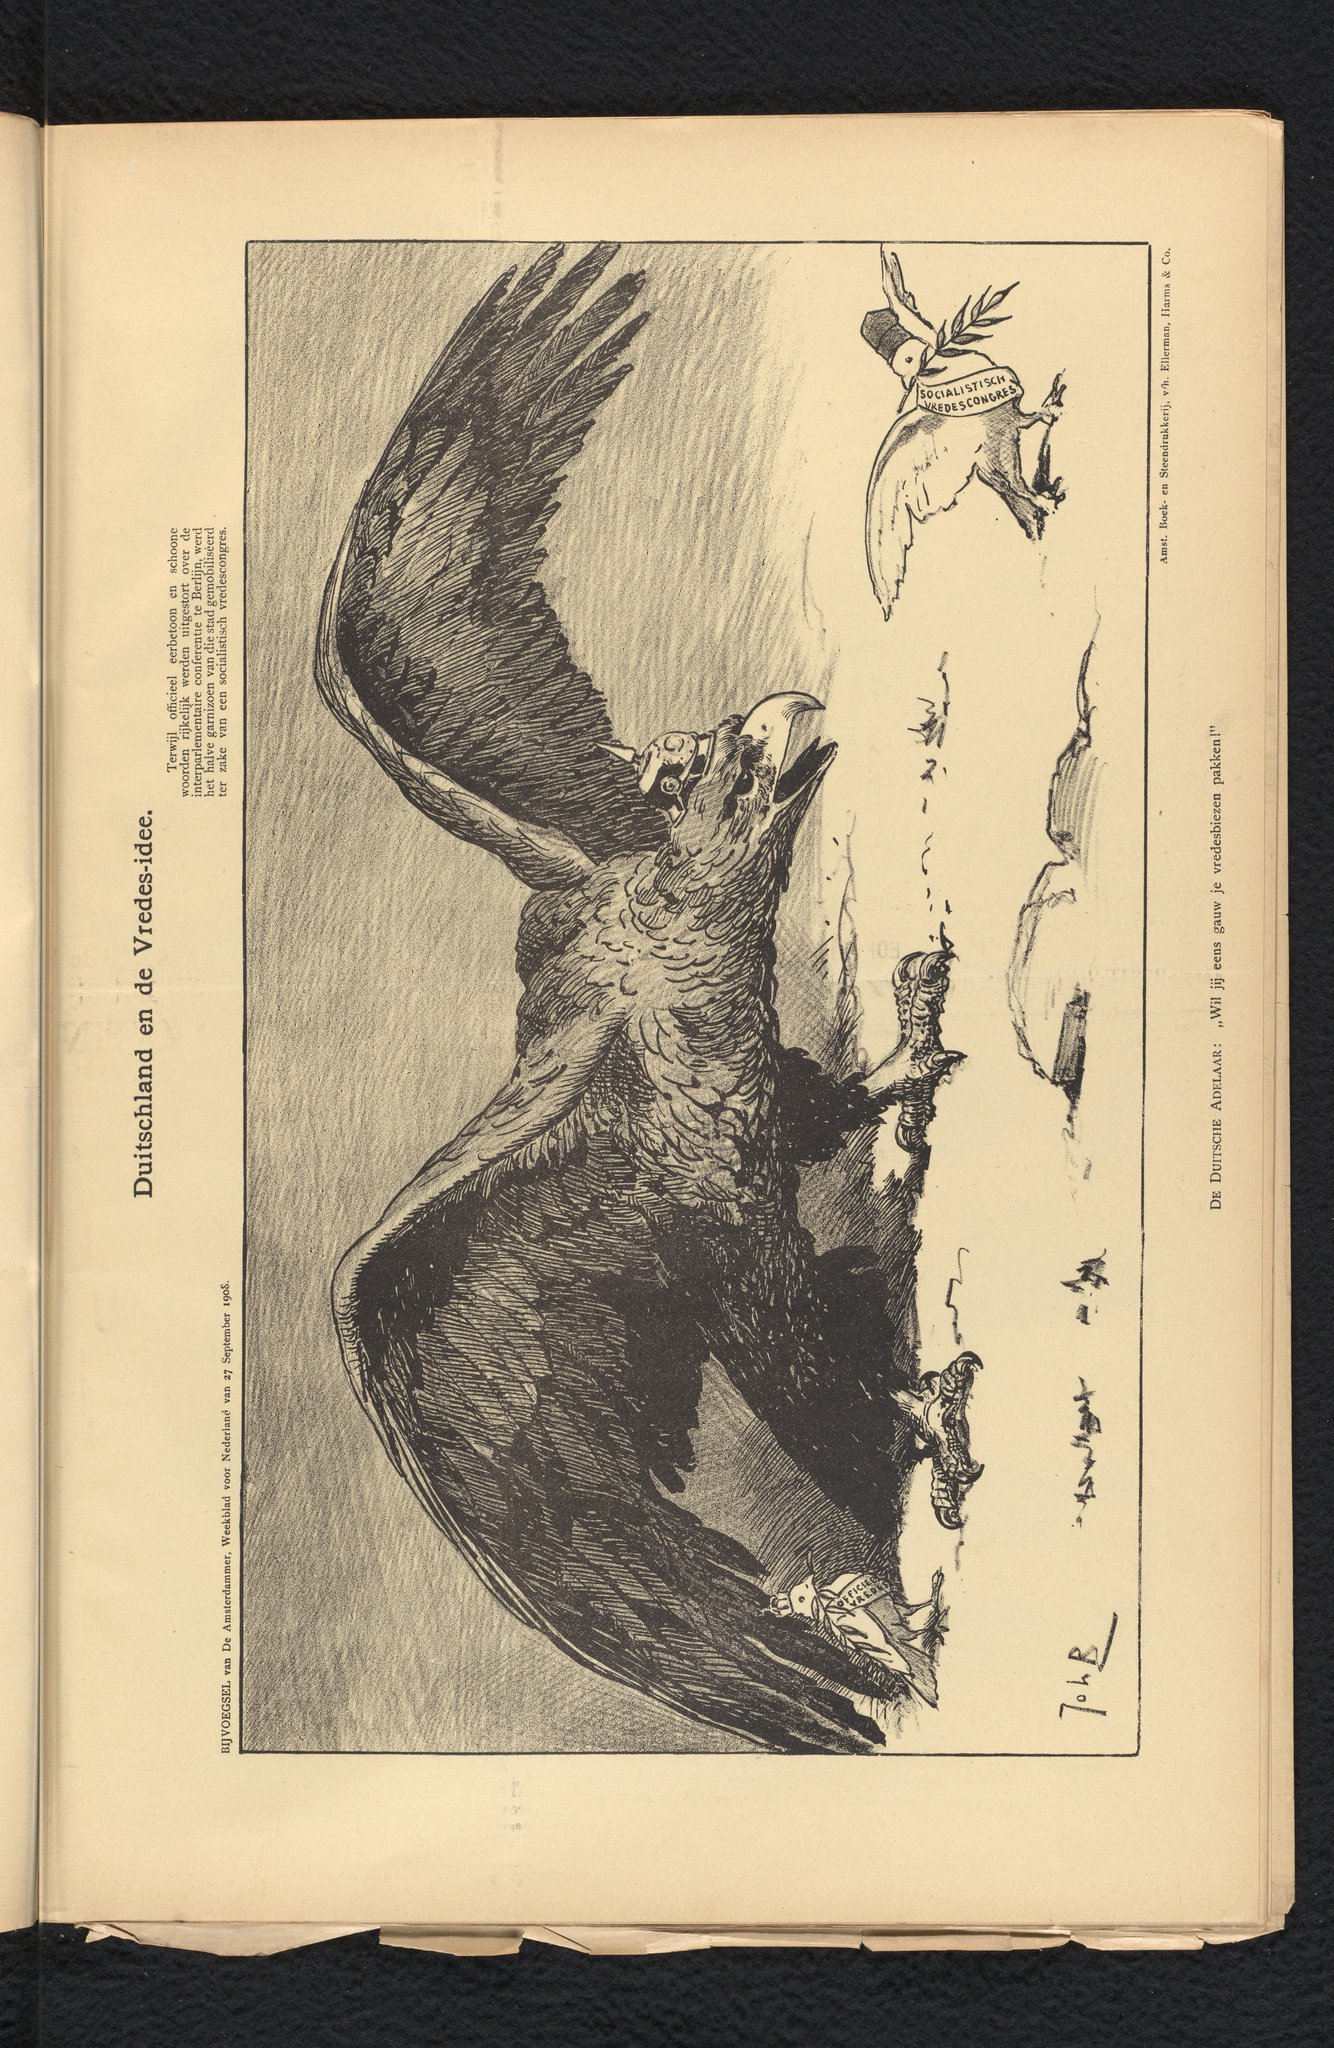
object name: cartoon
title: Duitschland en de Vredes-idee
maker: johan braakensiek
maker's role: draughtsman, print maker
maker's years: 1858-1940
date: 1908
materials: paper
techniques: lithograph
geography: netherlands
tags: predatory birds: eagle, personifications of countries, nations, states, districts, etc., symbols, allegories of peace, 'pax'; 'pace' (ripa), peace negotiations, political caricatures and satires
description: Een enorme Duitse adelaar verjaagt de kleine vredesduif van het 'socialistisch vredescongres', gehouden te Berlijn in september 1908.